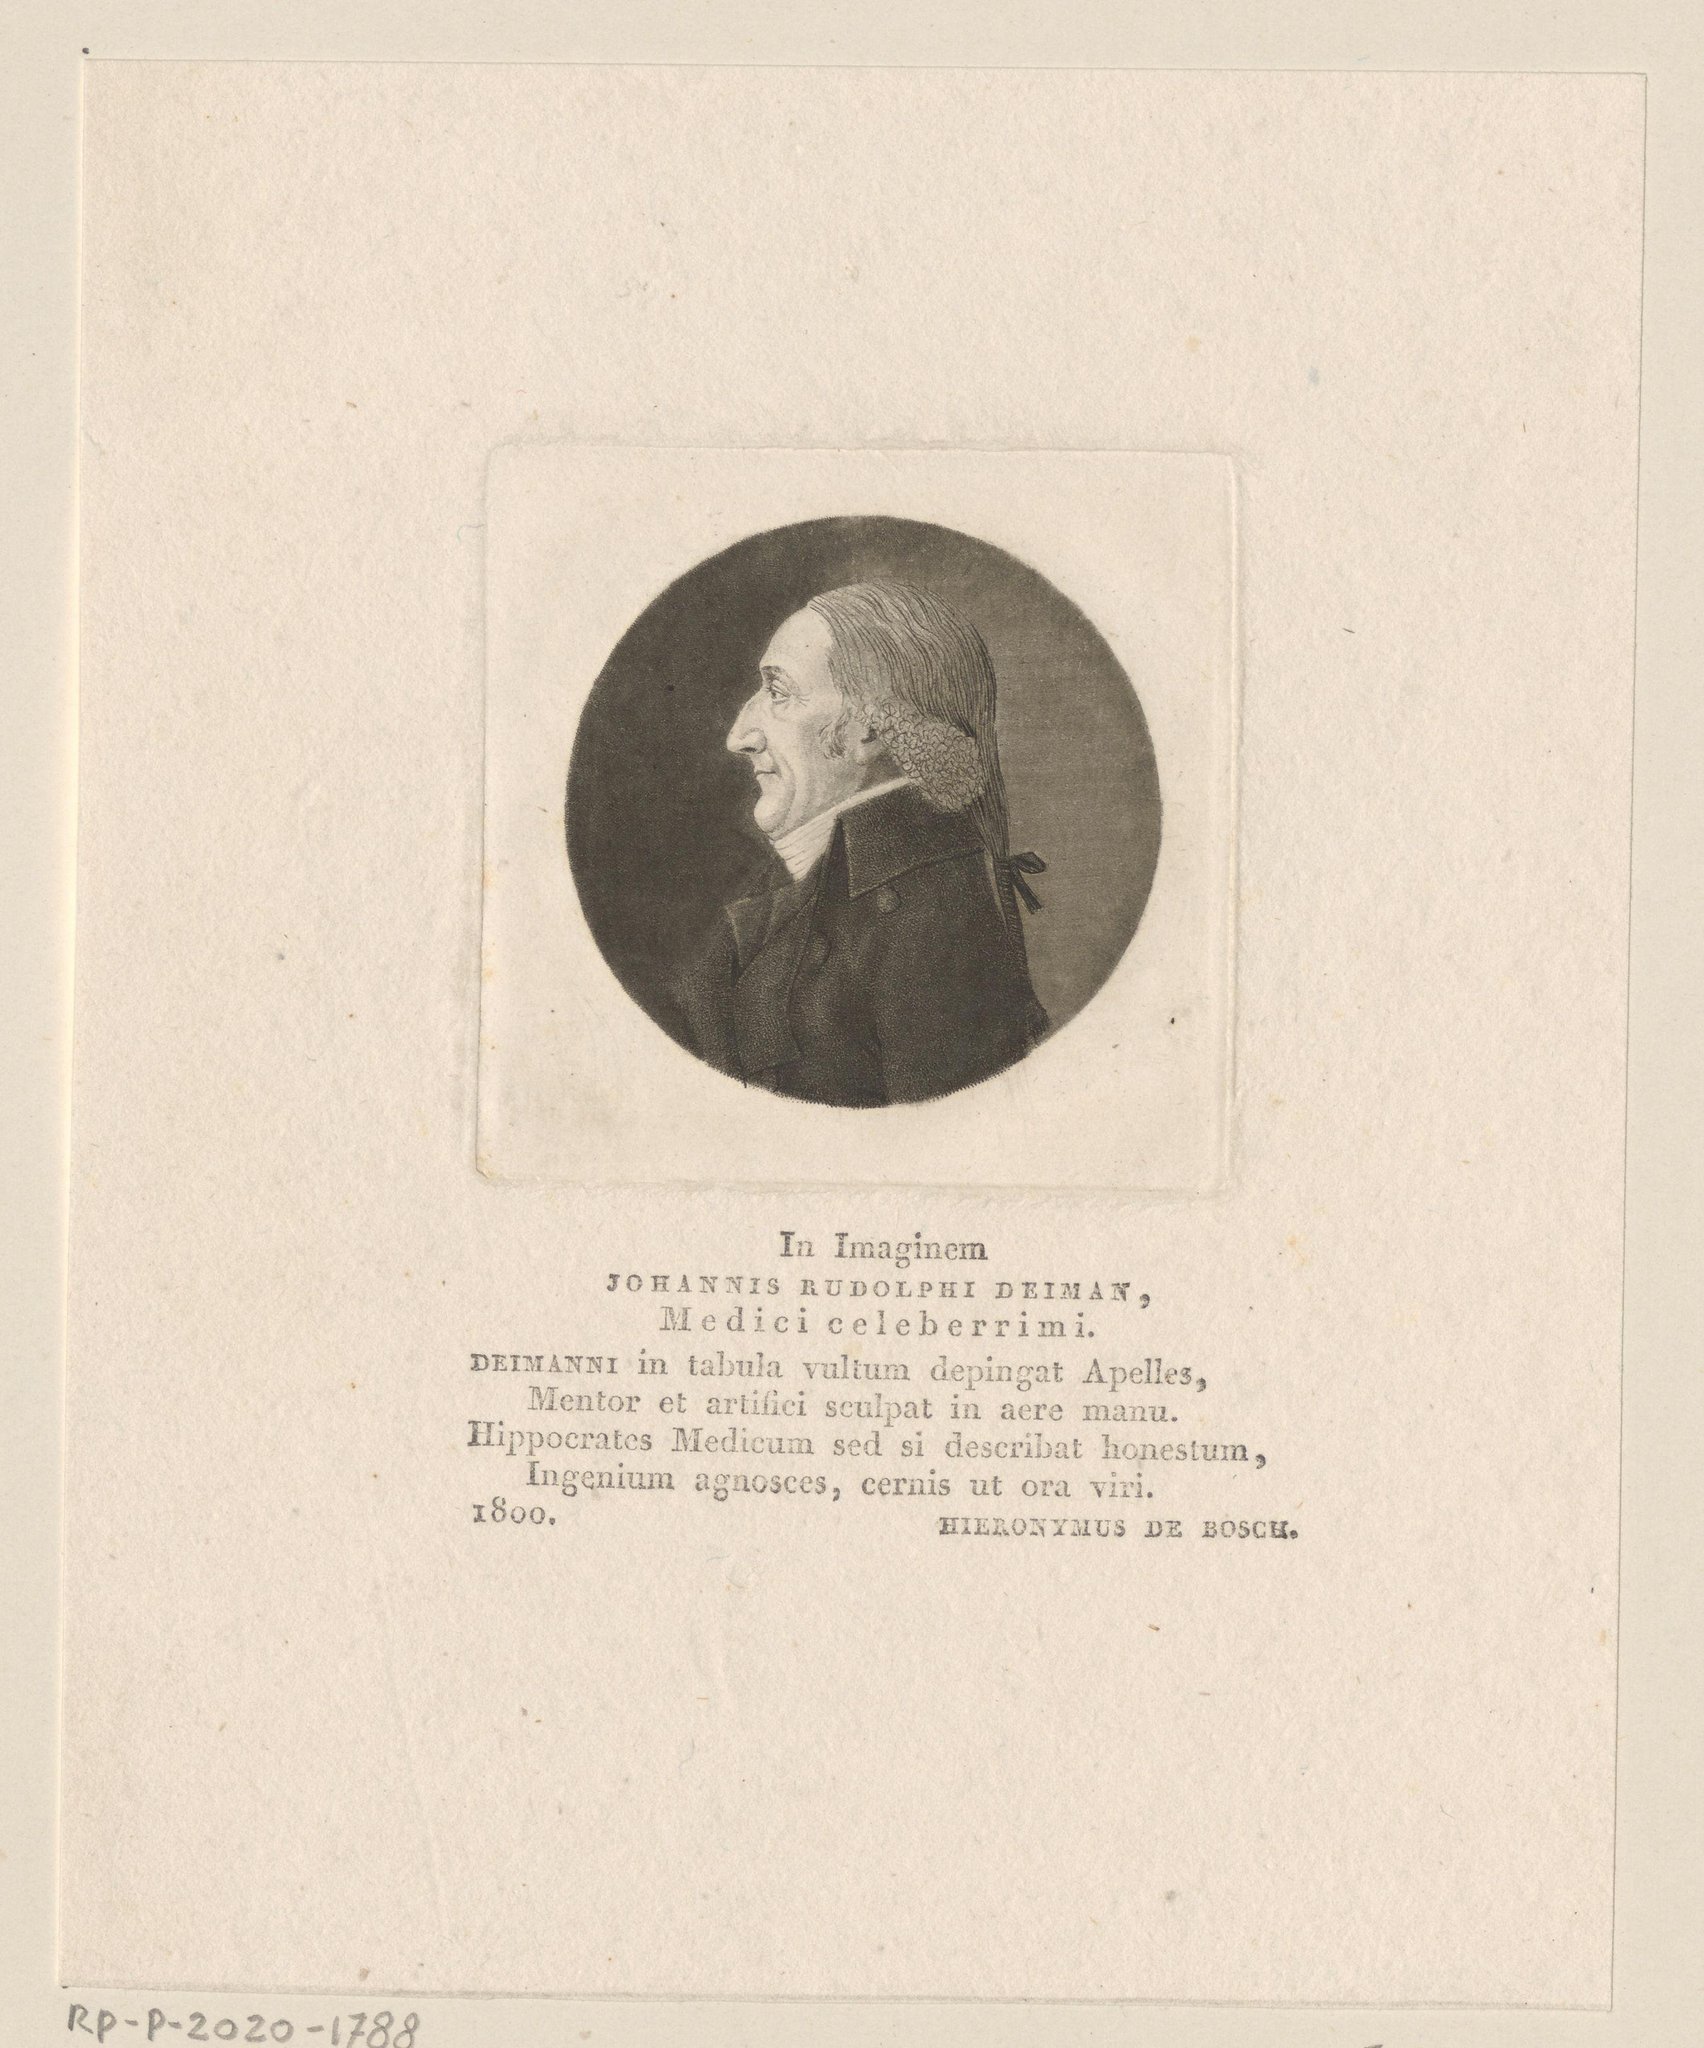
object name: print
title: Portret van Johan Rudolph Deiman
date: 1800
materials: paper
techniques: engraving, letterpress printing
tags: historical persons, physician, doctor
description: Prent met andere tekst in boekdruk gebruikt in: Doornik, Jacob Elisa, en Johannes Kinker. Johan Rudolph Deiman gedacht in eene redevoering (...). Amsterdam: J.S. van Esveldt-Holtrop, 1808.